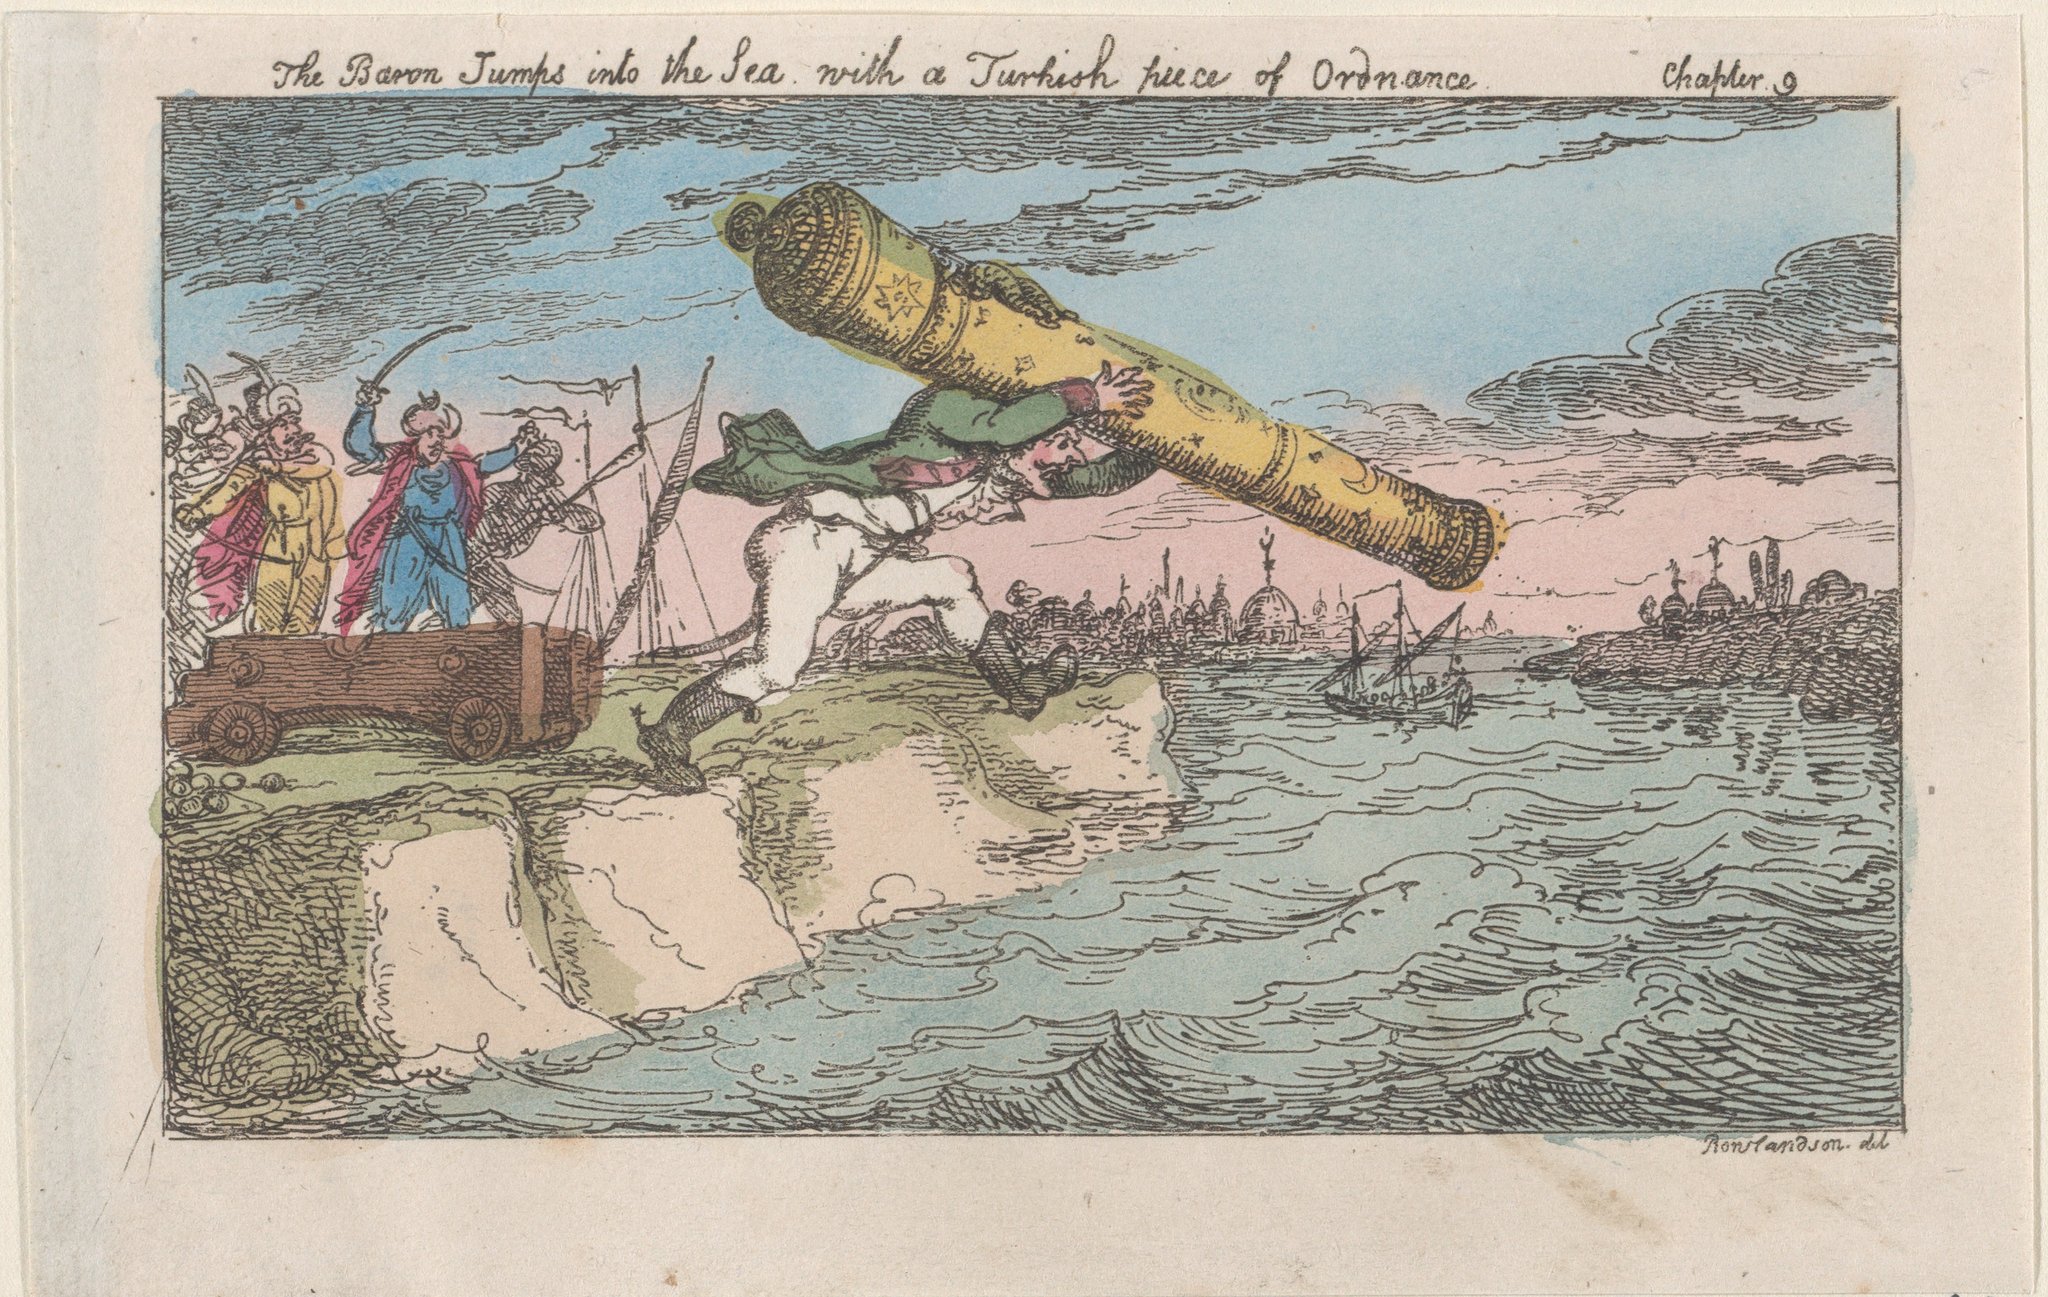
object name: print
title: The Baron Jumps into the Sea with a Turkish piece of Ordnance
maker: thomas rowlandson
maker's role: artist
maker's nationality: british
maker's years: 1757-1827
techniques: etching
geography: london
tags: satire,cannons,men